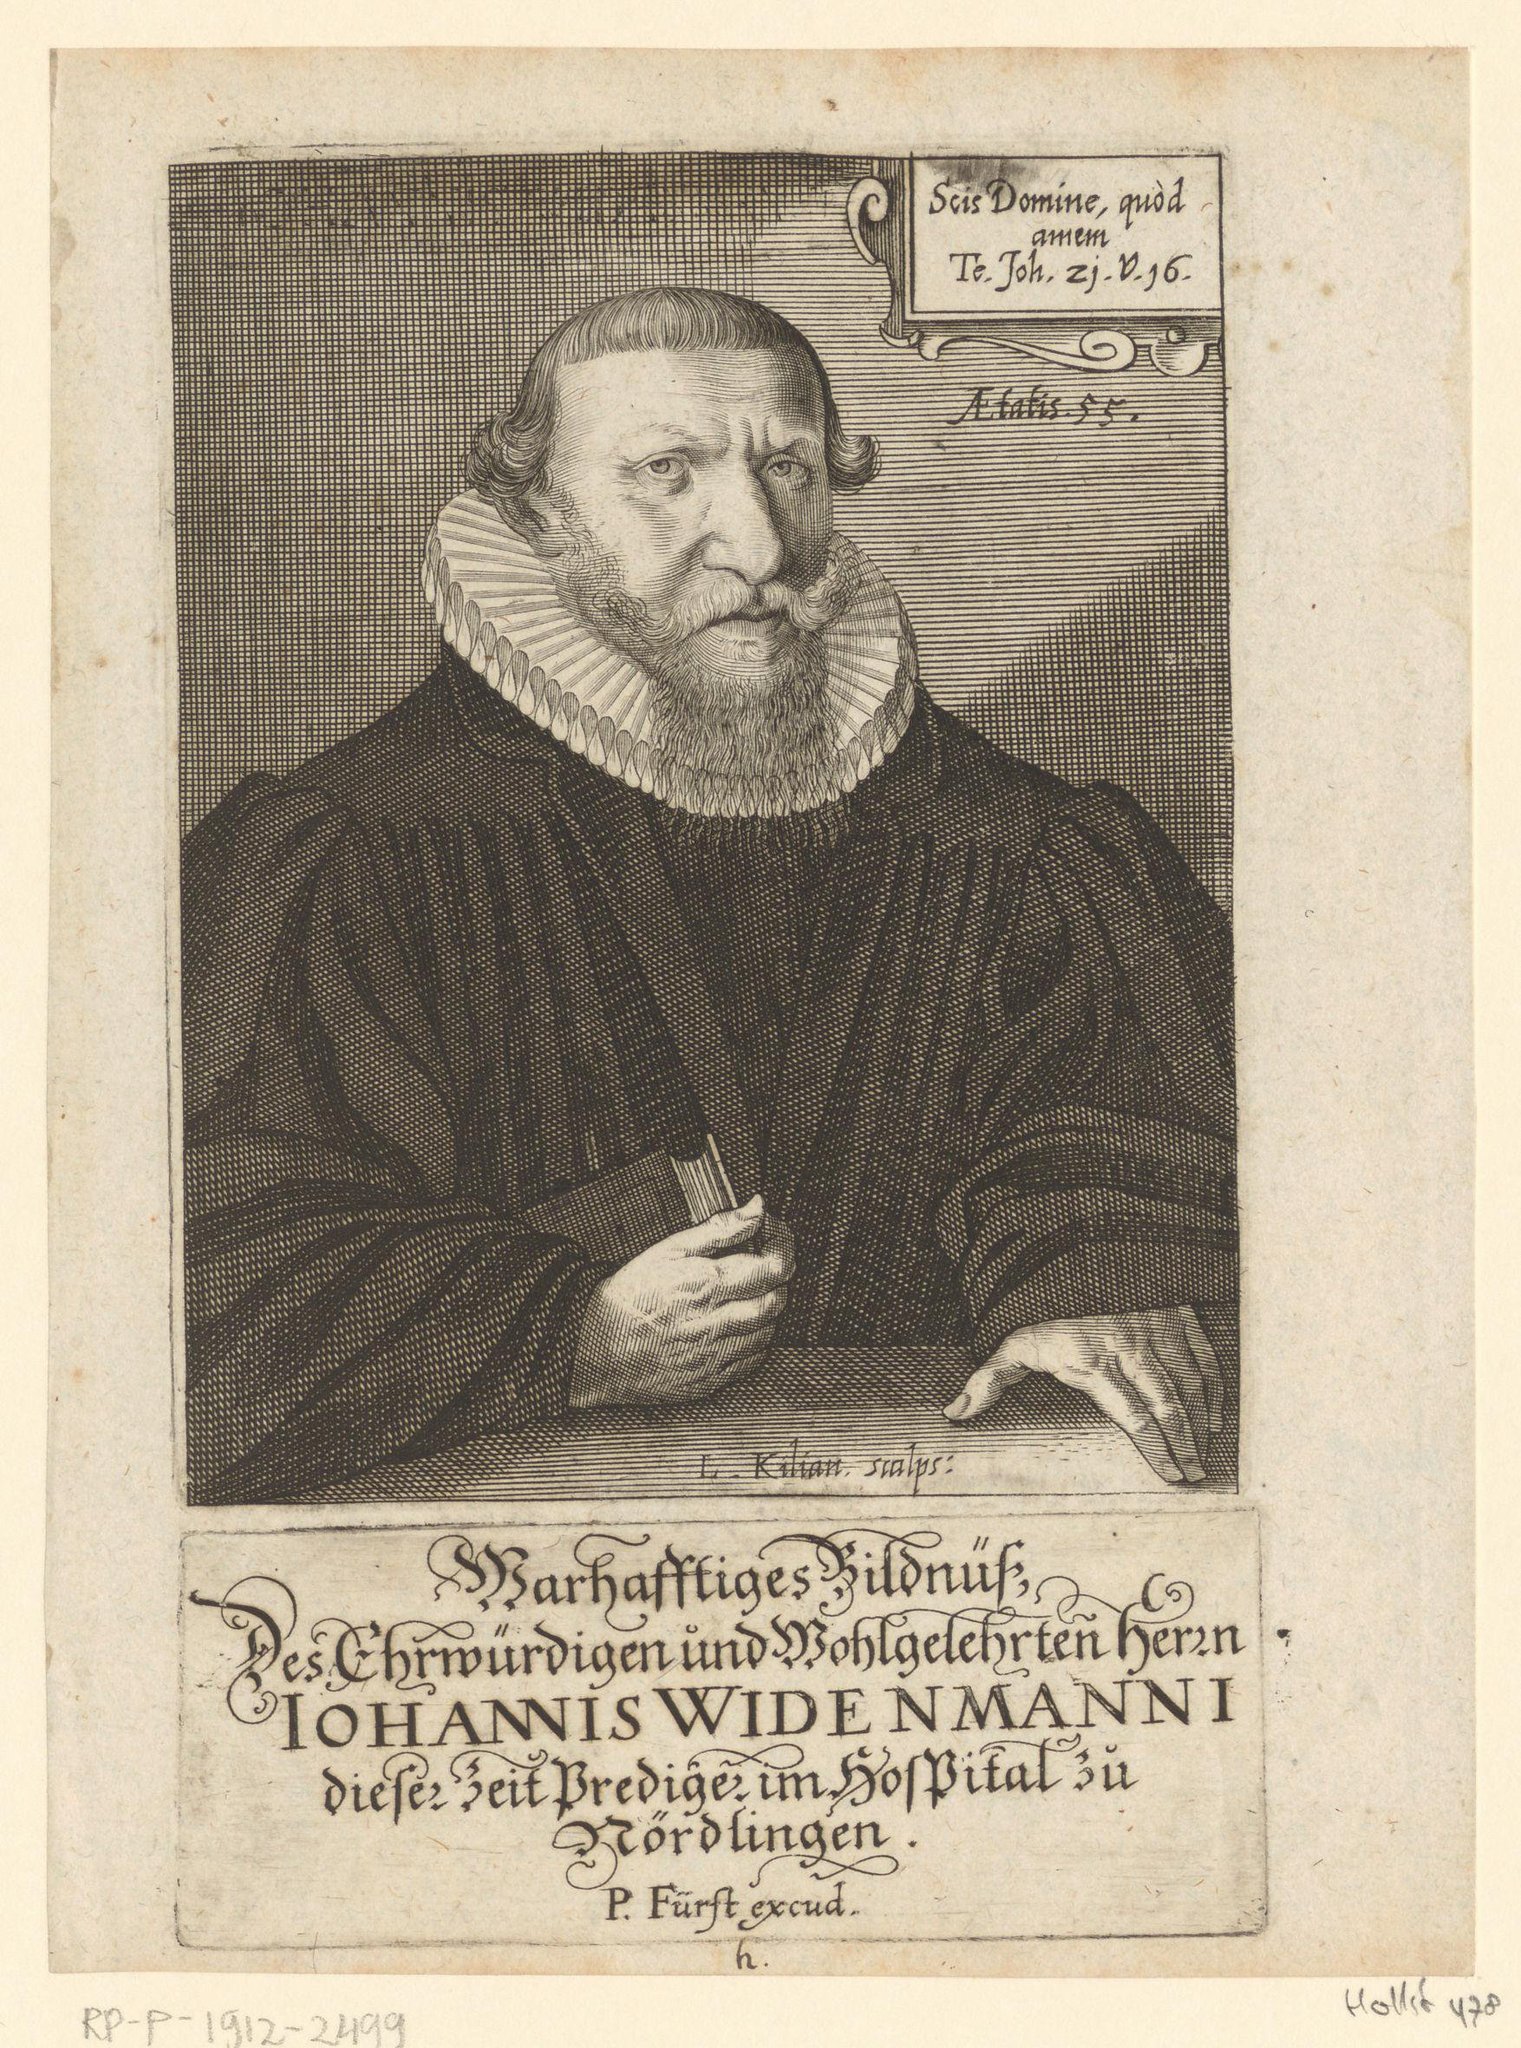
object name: print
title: Portret van Johann Widenmann op 55-jarige leeftijd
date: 1615-1637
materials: paper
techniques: engraving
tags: theologian, historical persons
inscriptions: collector's mark: Lugt 2228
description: Tekst in het Latijn in het kader bij het portret. De druk onderaan het blad heeft tekst in het Latijn.